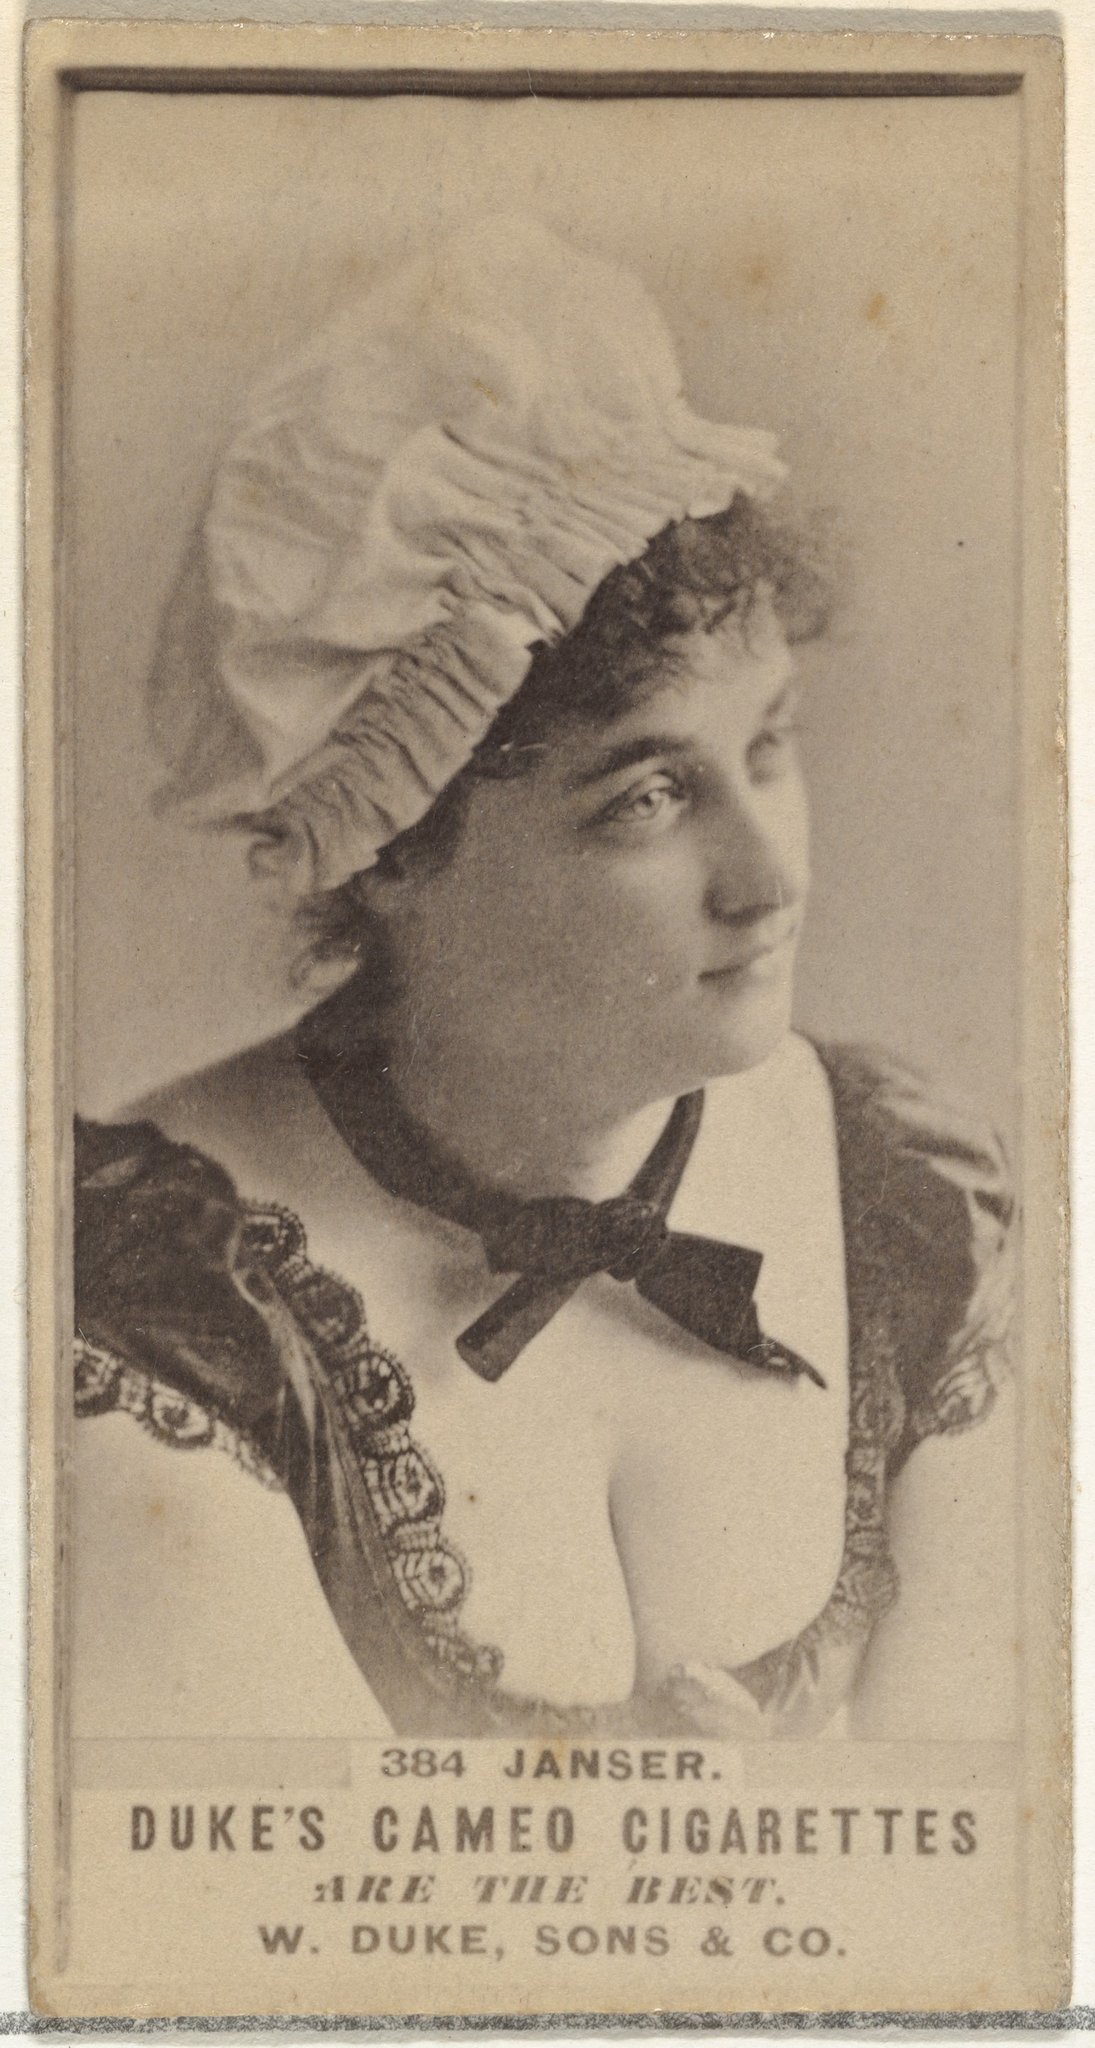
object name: photograph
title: Card Number 384, Miss Janser, from the Actors and Actresses series (N145-5) issued by Duke Sons & Co. to promote Cameo Cigarettes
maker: w. duke, sons & co.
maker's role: publisher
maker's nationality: american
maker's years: 1870-1920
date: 1880-1889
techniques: albumen silver print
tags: portraits,women,actresses